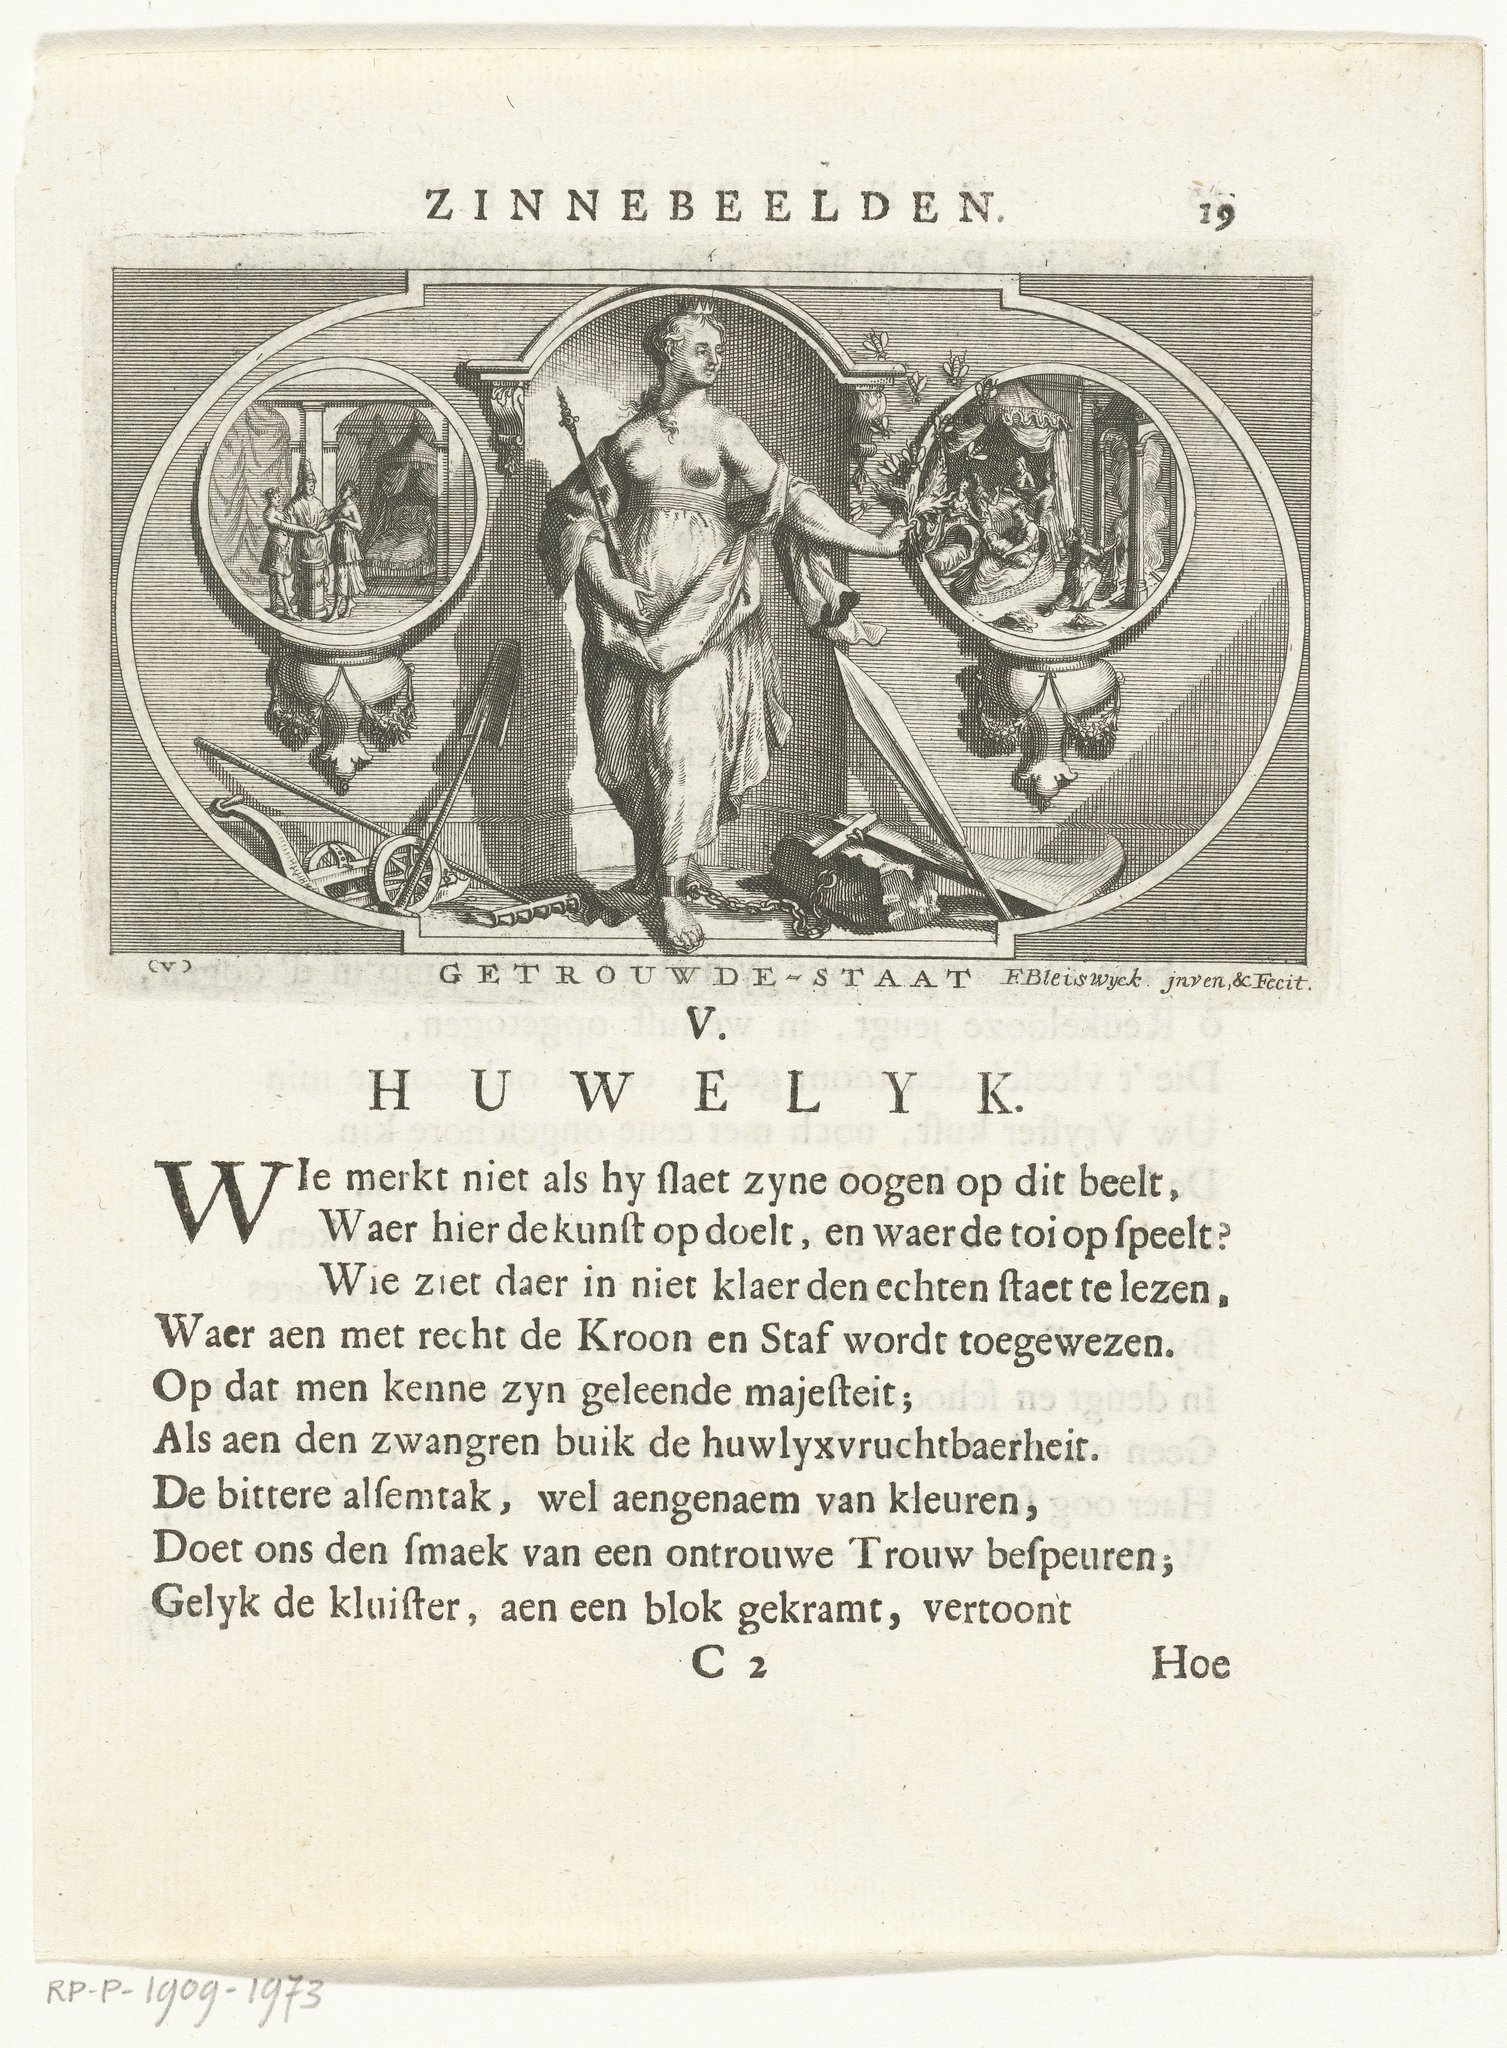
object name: book illustration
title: Getrouwde-staat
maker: françois van bleyswijck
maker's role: draughtsman, print maker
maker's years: 1671-1746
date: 1681-1737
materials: paper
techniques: etching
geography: leiden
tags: 'castità matrimoniale', 'fede maritale', 'matrimonio' (ripa)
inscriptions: collector's mark: Lugt 2228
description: Embleem met allegorie op het huwelijk verbeeld als een geketende vrouw met kroon en scepter. Twee medaillons tonen scènes van een huwelijksvoltrekking en de geboorte van een kind. Bij de voeten van de vrouw liggen landbouwwerktuigen zoals ploeg en schop en ook een roer. Onder de voorstelling en op het verso staat een gedicht.